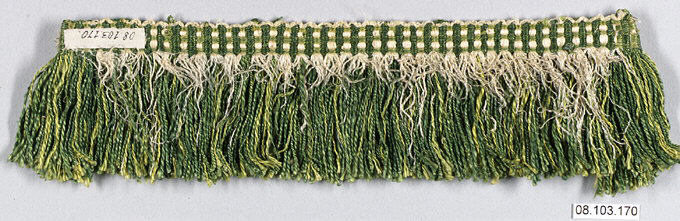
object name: fringe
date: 1601-1800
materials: silk